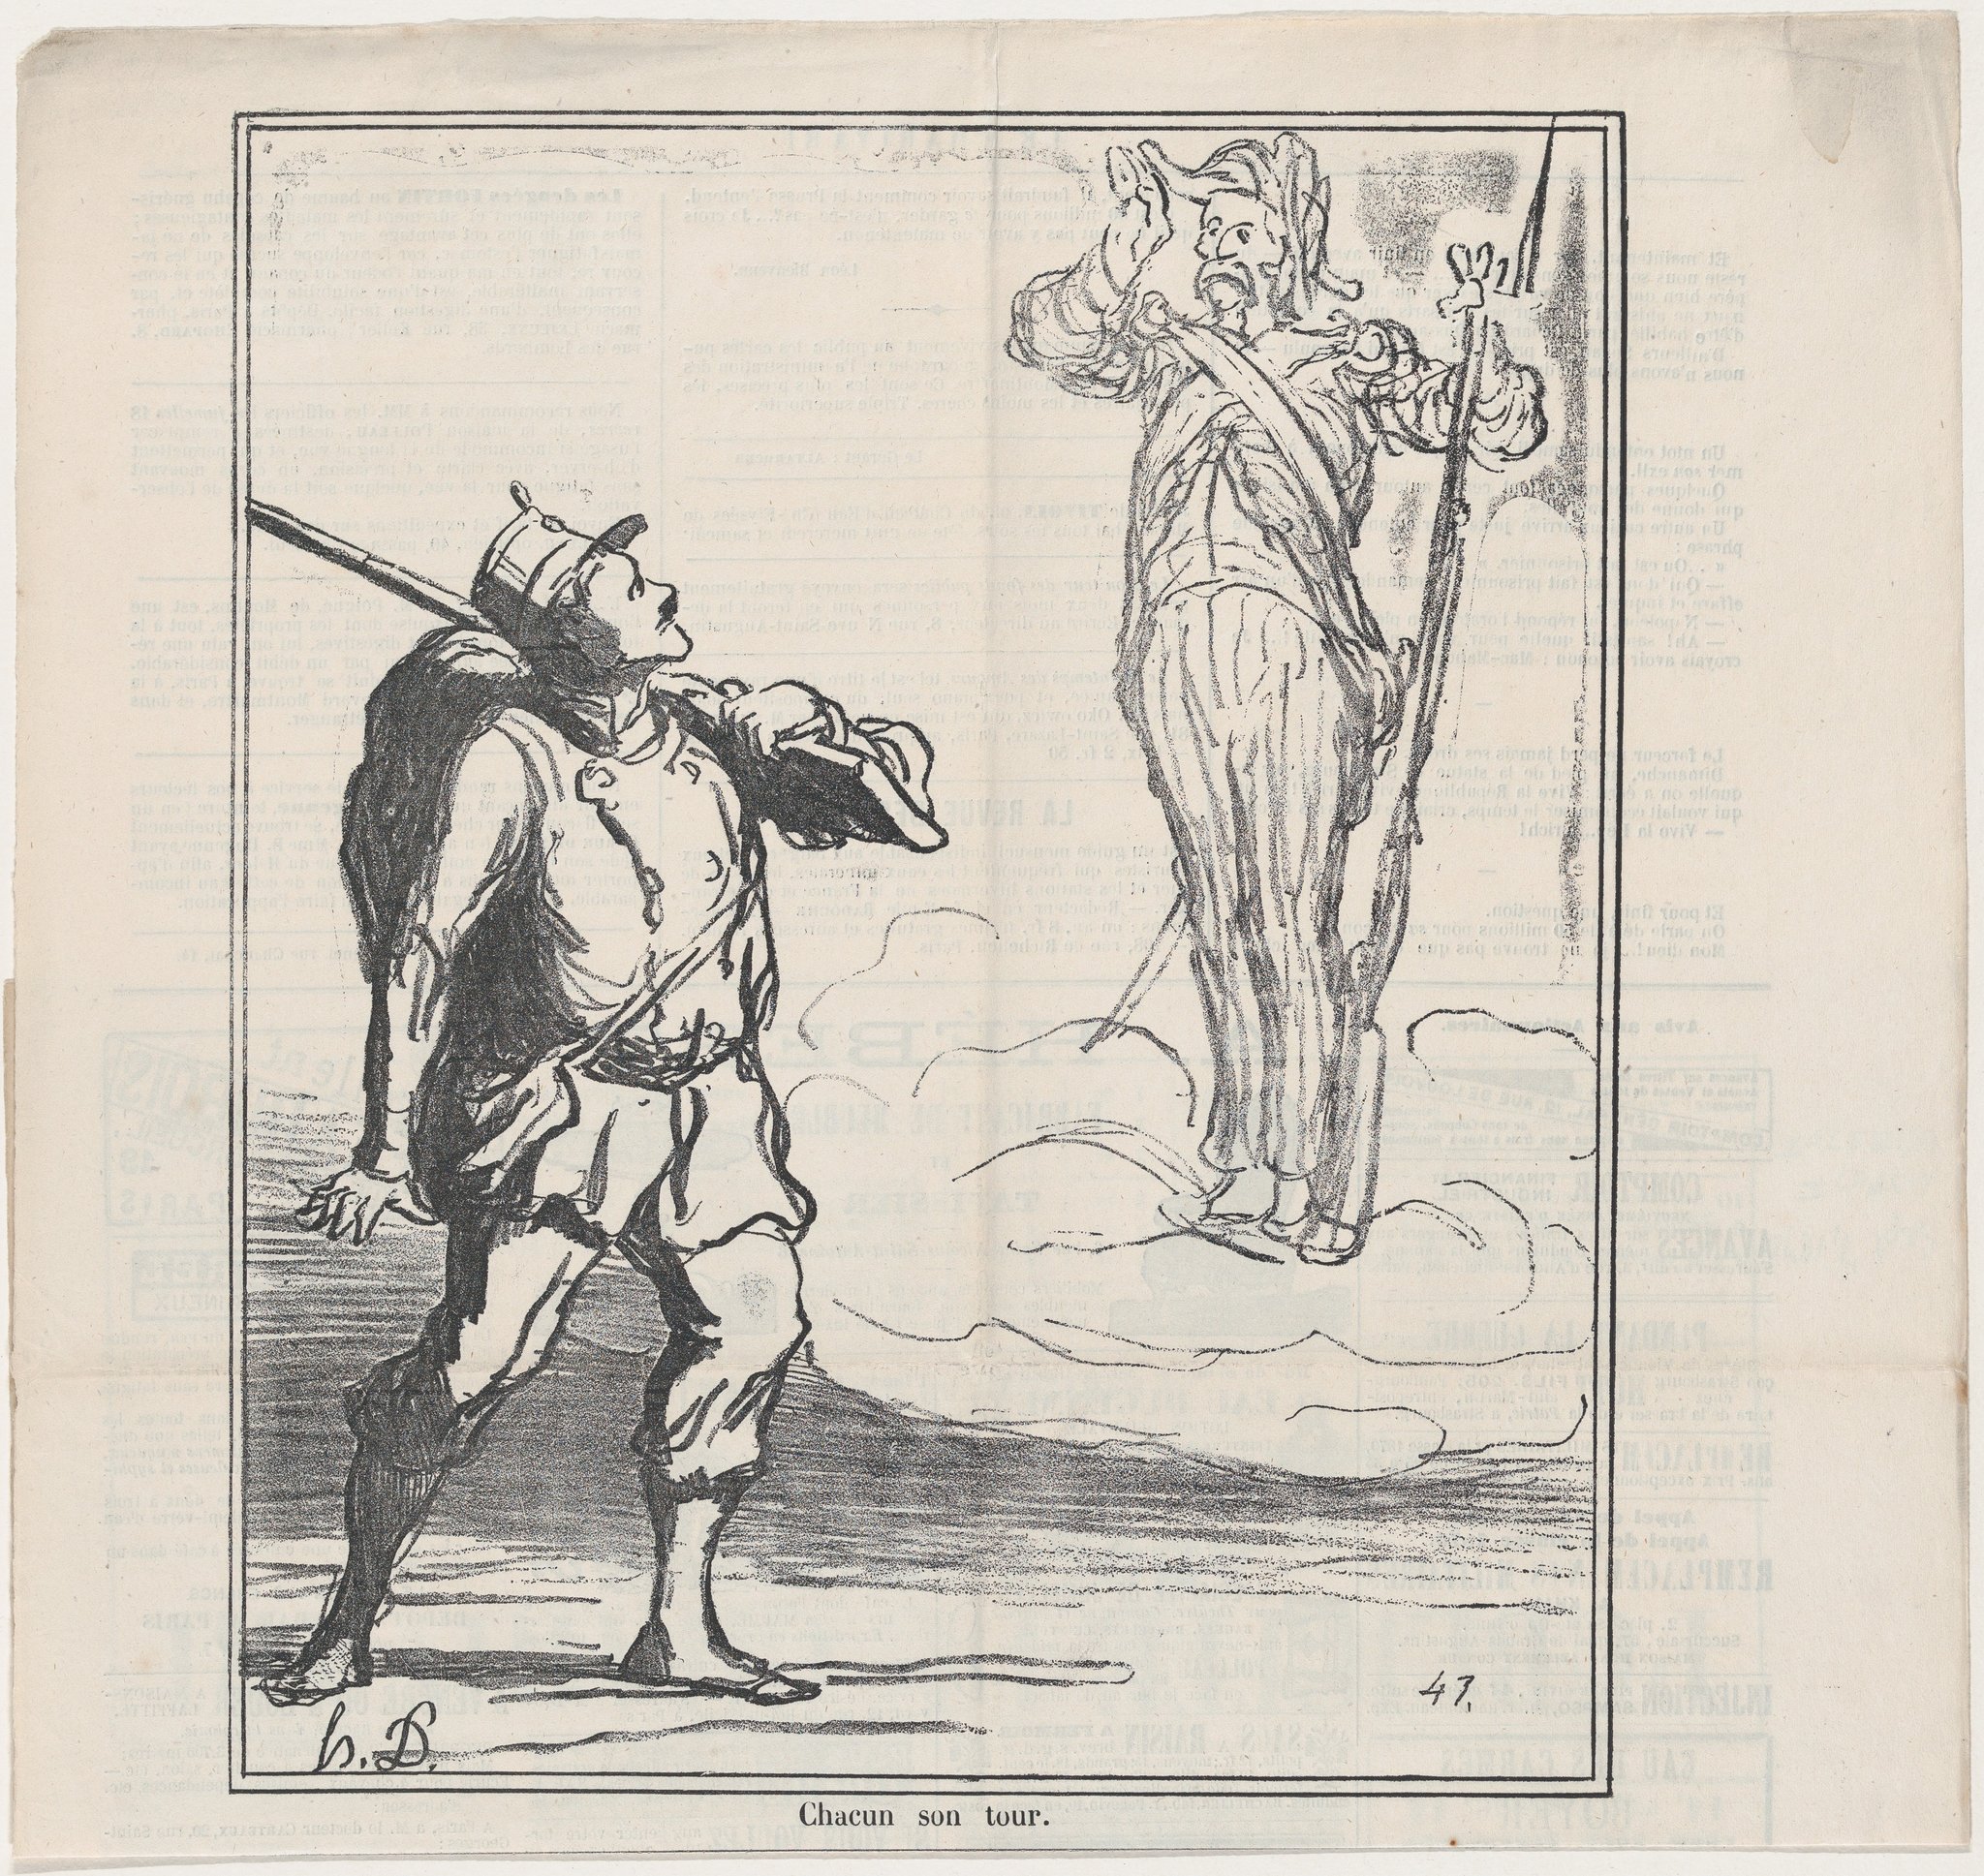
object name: print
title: Un Leçon de Botanique, from "Croquis Parisiens"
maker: honoré daumier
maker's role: artist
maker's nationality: french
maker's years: 1808-1879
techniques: lithograph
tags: firearms,men